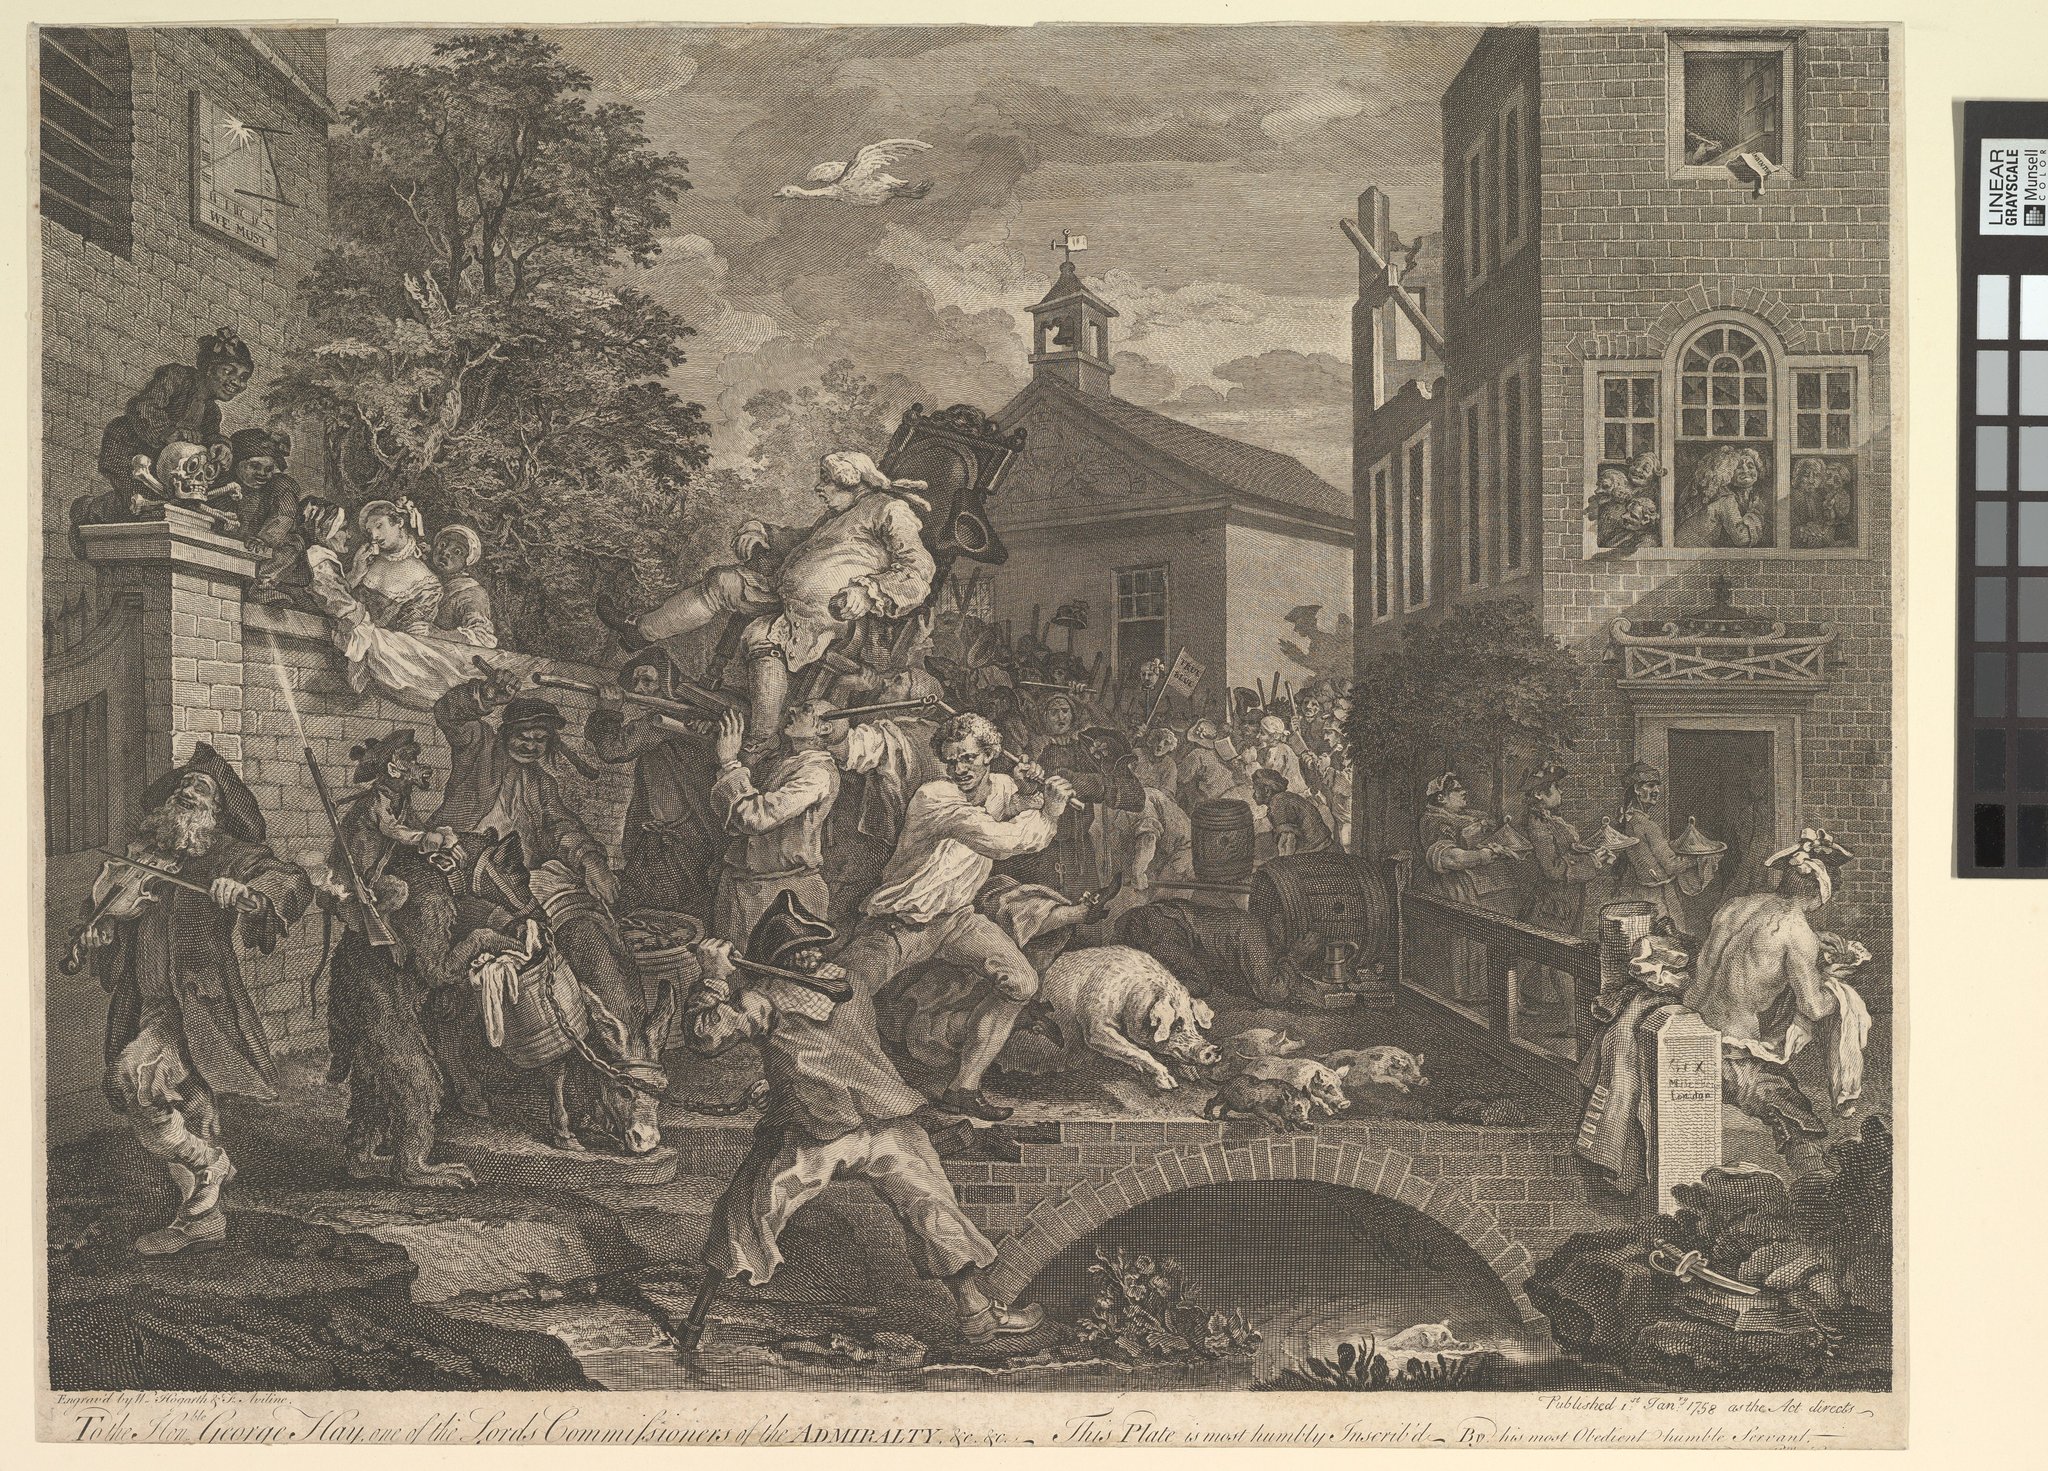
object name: print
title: Chairing the Members, Plate IV: Four Prints of an Election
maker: william hogarth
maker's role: artist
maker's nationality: british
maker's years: 1697-1764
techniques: engraving, etching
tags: men,women,pigs,crowd